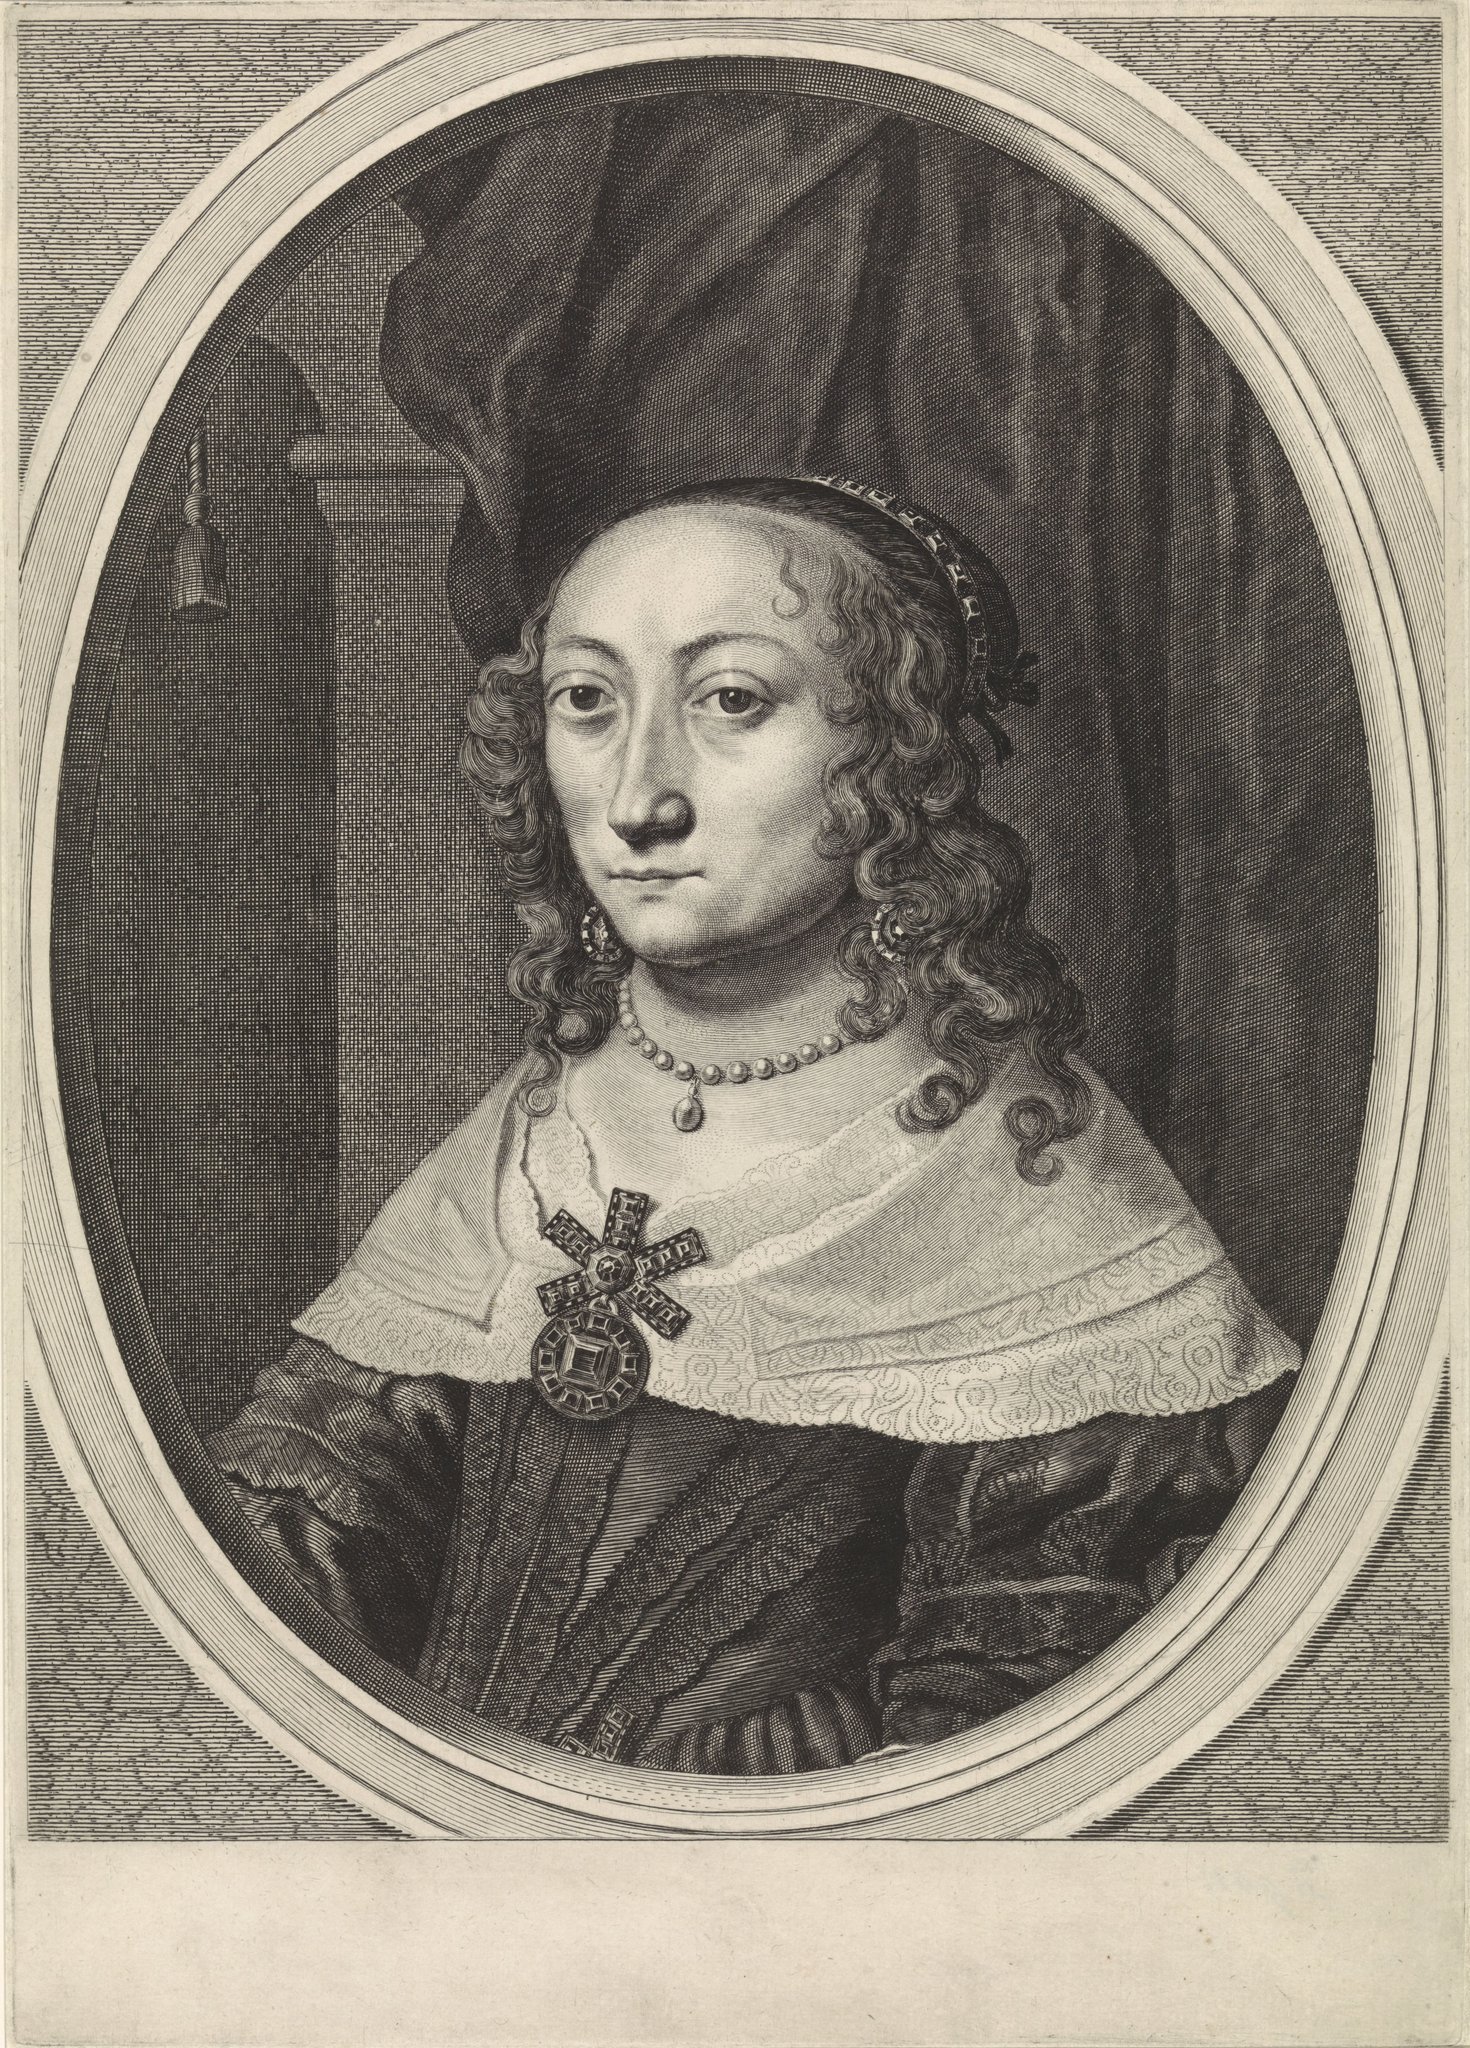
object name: print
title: Portret van Catherina Charlotta, paltsgravin van Palts-Neuburg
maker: theodor matham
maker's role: draughtsman, print maker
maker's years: 1605-1676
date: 1635-1653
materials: paper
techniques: engraving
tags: ornaments, jewels, pearl; pearl necklace (+ women's clothes)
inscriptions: collector's mark: Lugt 2228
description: Portret van Catherina Charlotta, paltsgravin van Palts-Neuburg, vrouw van Wolfgang Willem van de Palts-Neuburg. Om haar hals een parelsnoer met een hanger en op haar borst een juwelen speld.